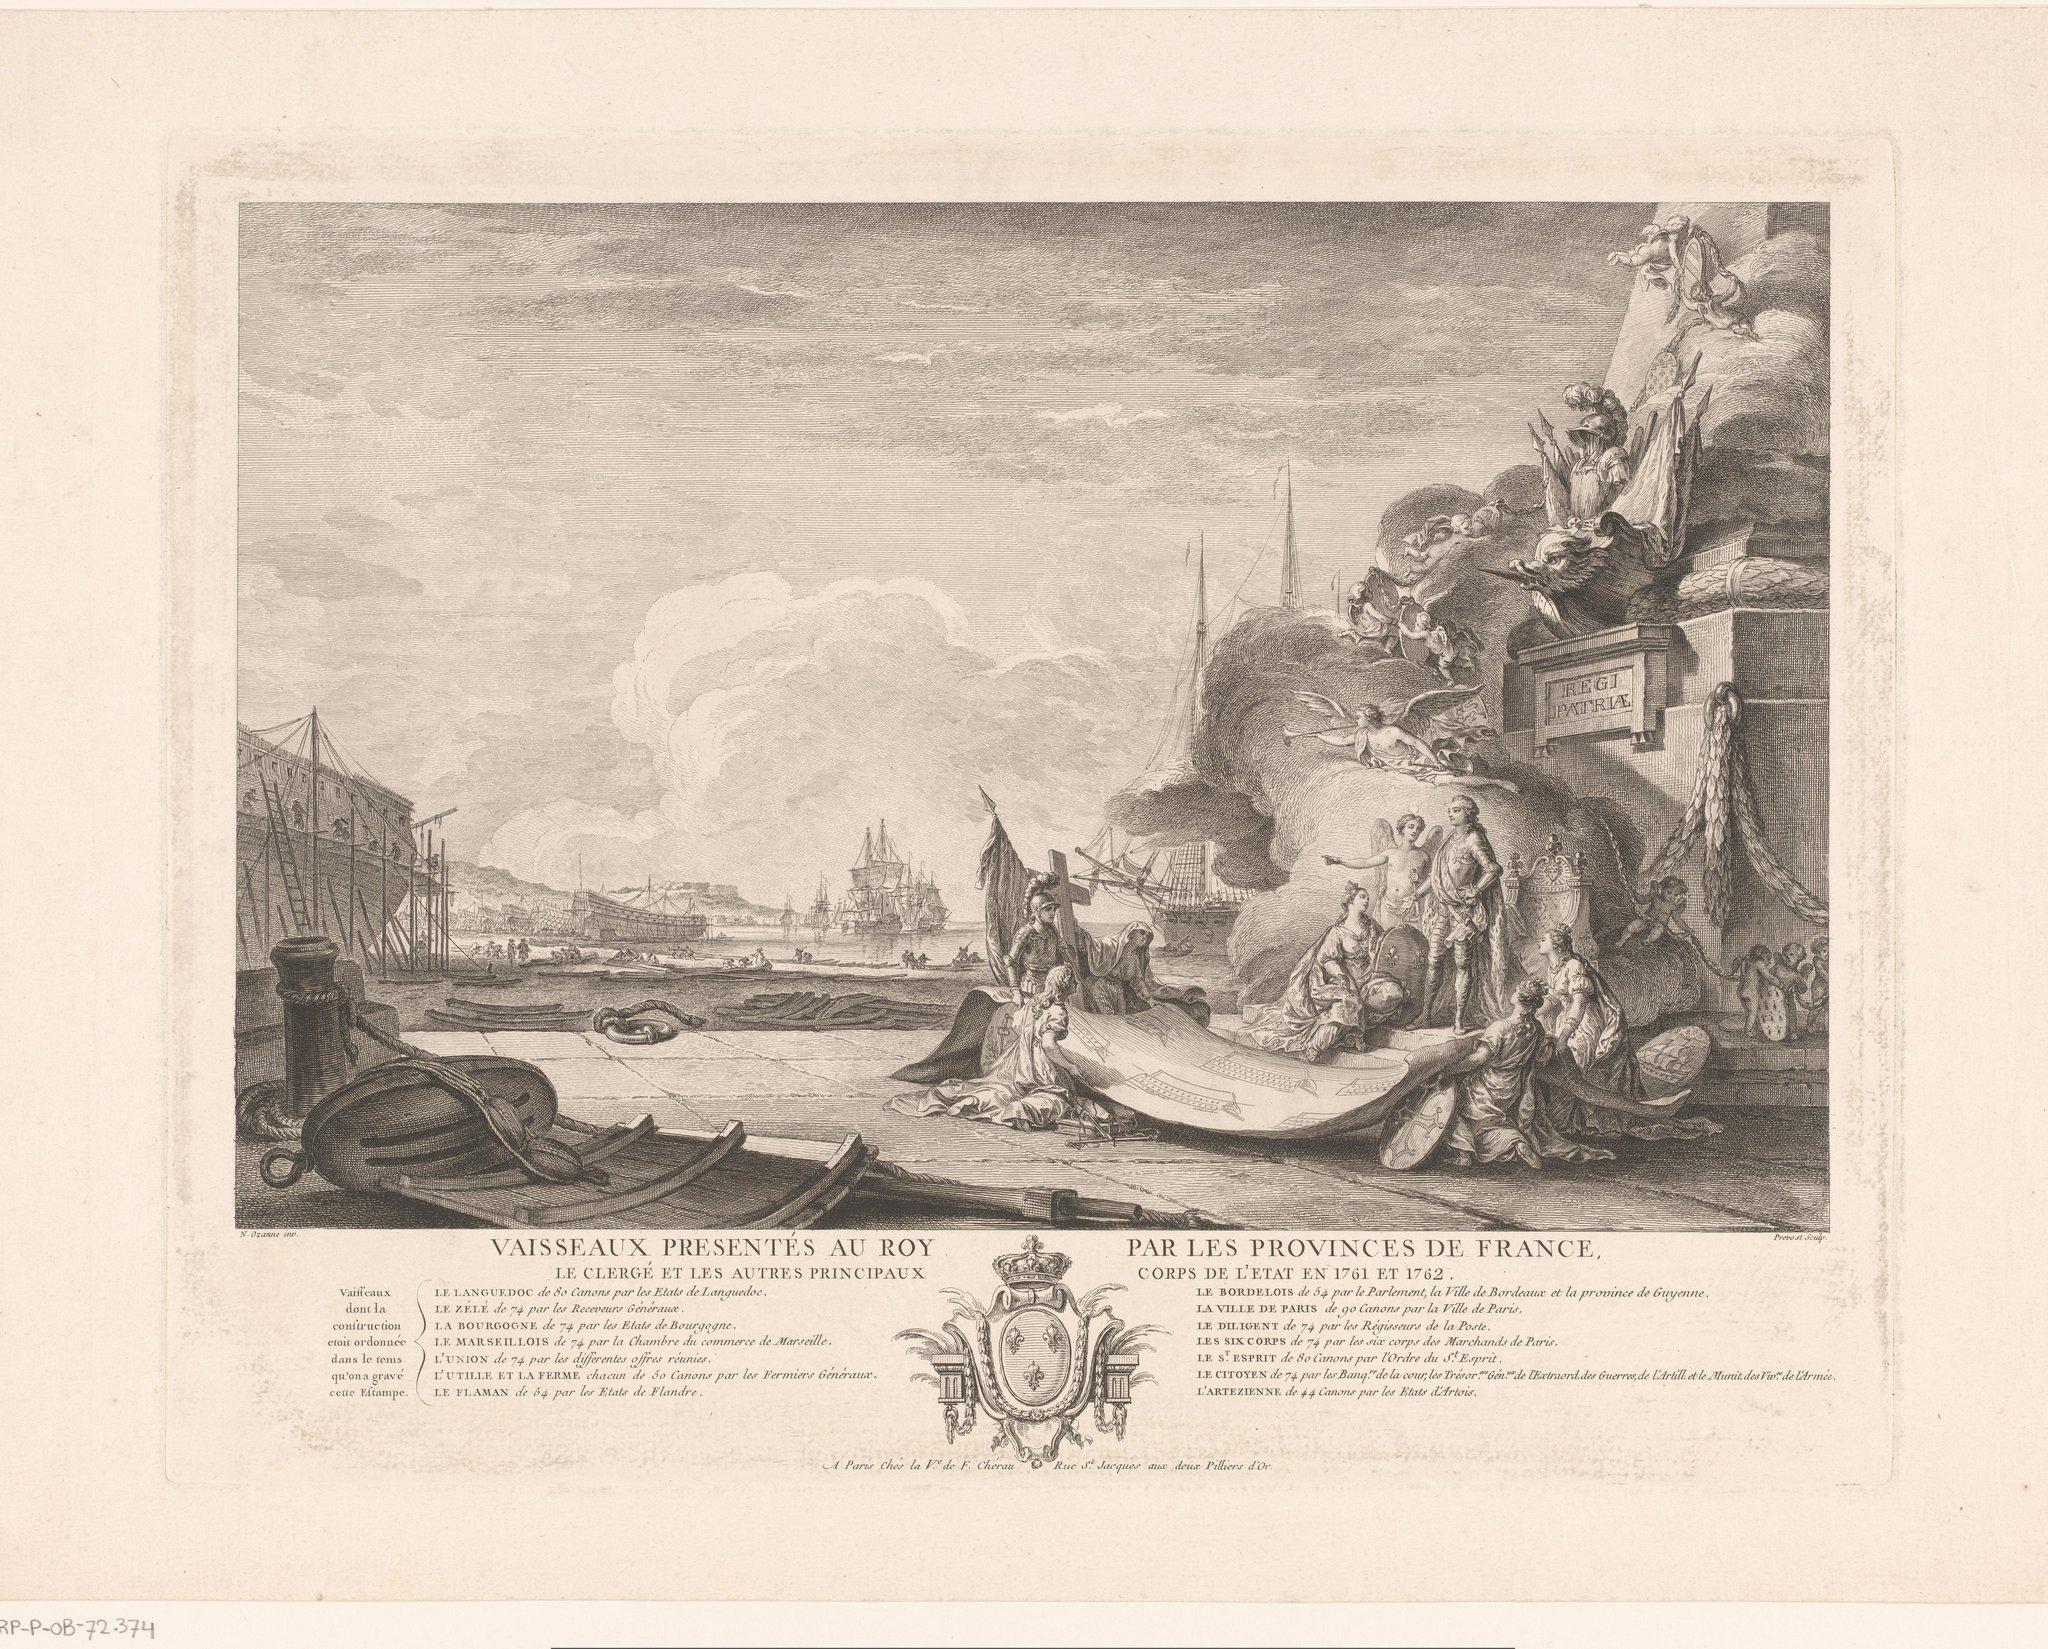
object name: print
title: Schepen getoond aan de koning door de Franse provincies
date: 1761-1762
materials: paper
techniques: engraving, etching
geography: paris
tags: louis xv of france, ships (in general)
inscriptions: collector's mark: Lugt 2228